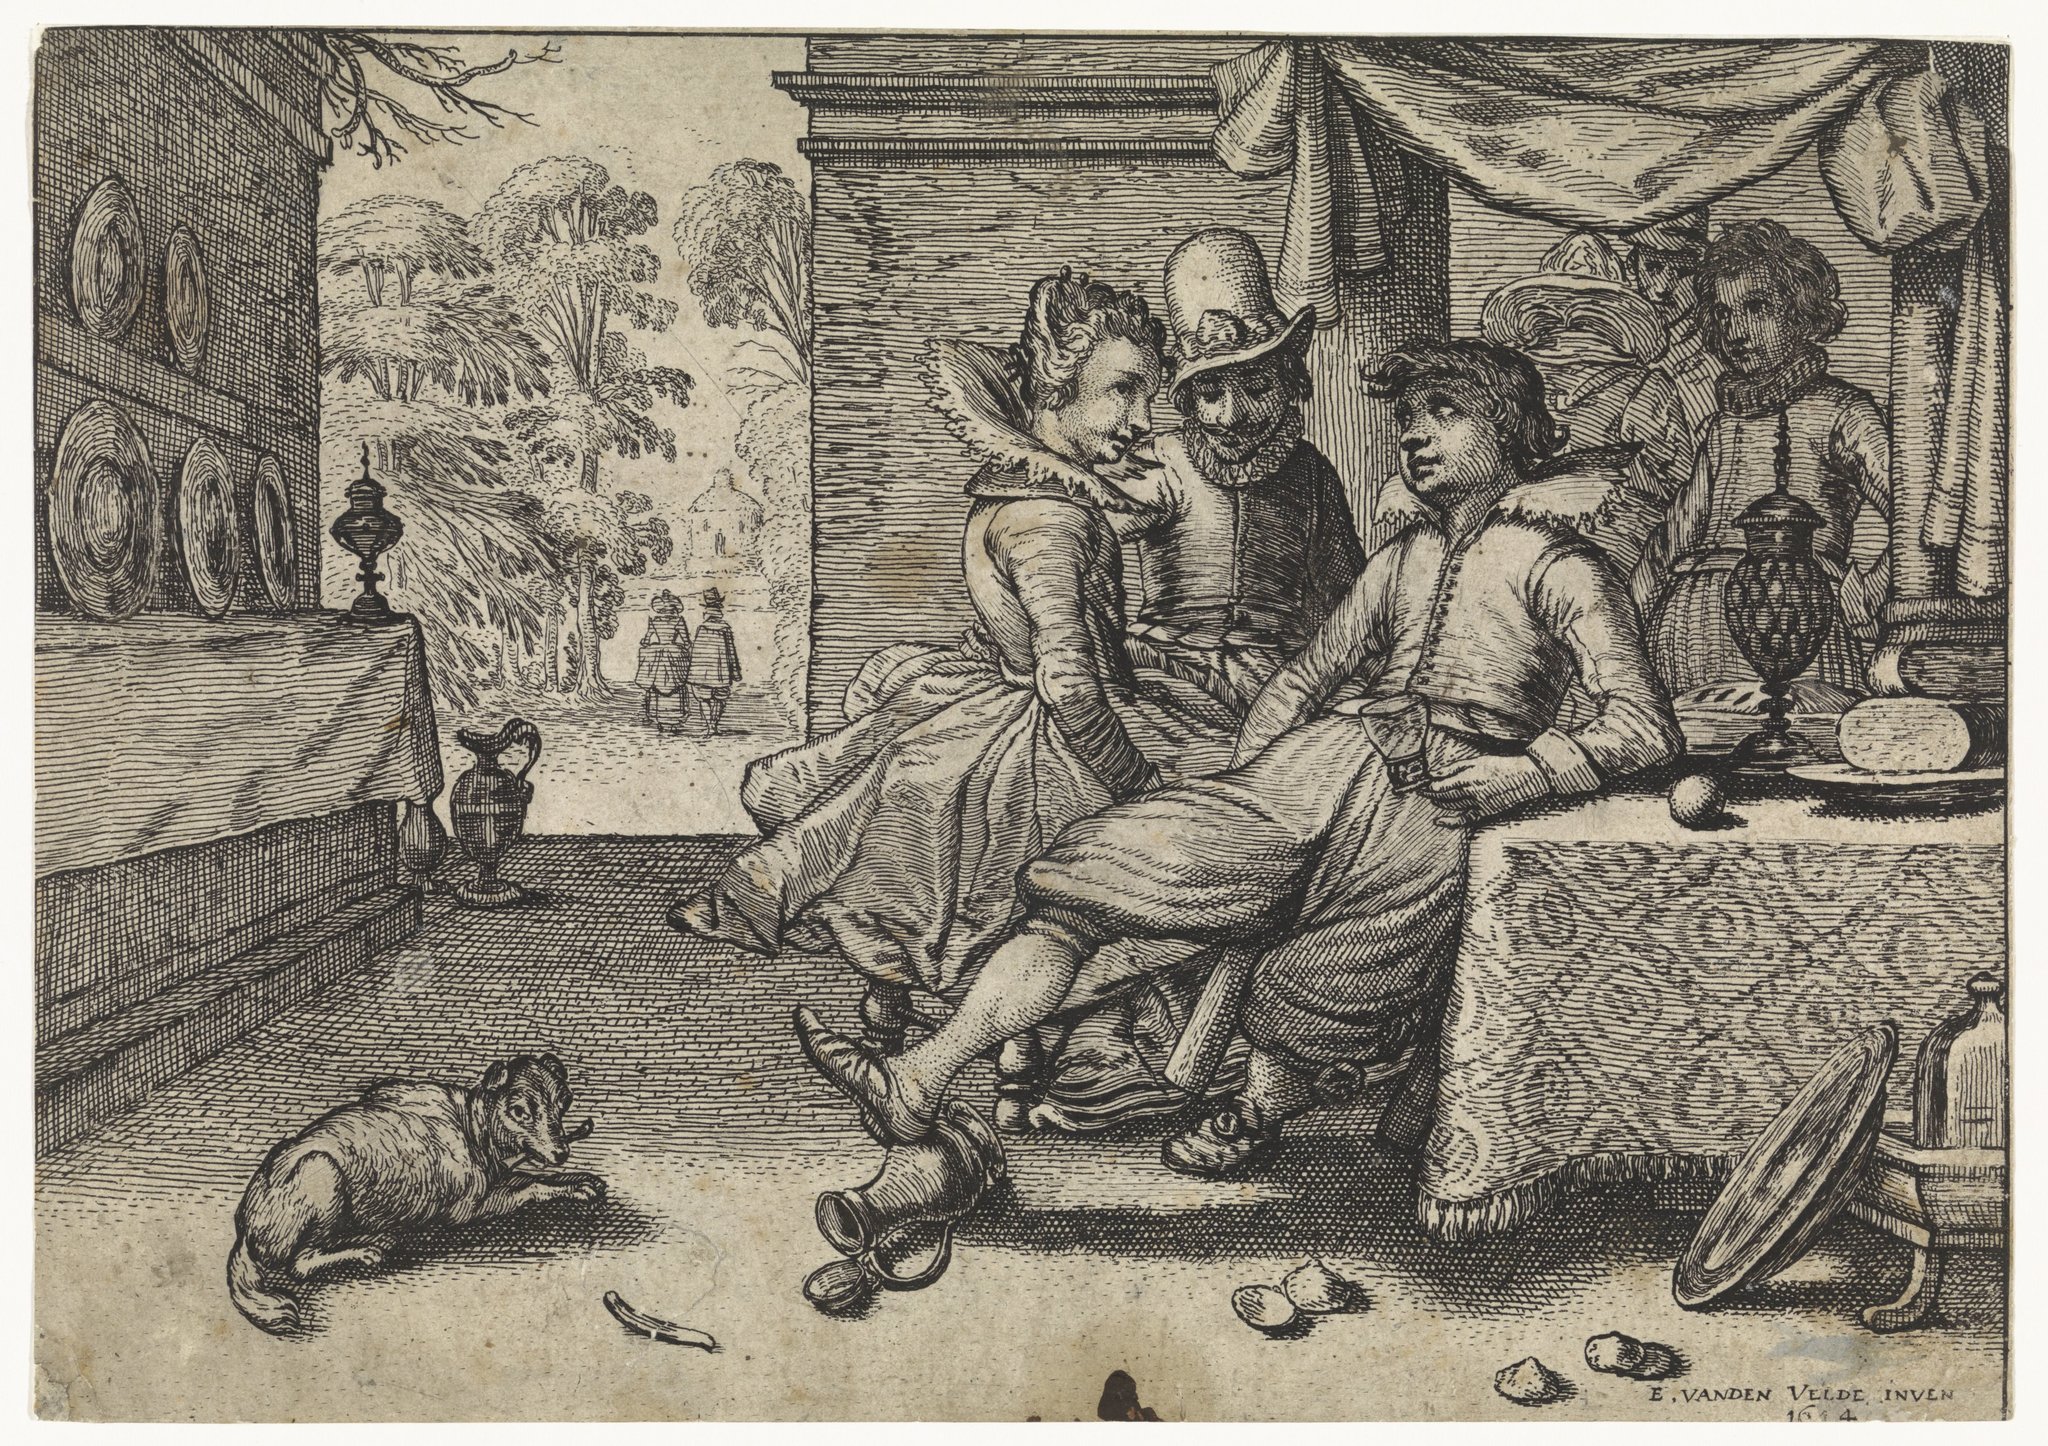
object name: print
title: Elegant gezelschap aan gedekte tafel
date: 1614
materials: paper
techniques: engraving, etching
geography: amsterdam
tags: private festivities, merry company - aa - in the open air, 'fête champêtre', laid table: table-ware, table-decoration, etc., wine-cooler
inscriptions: collector's mark: Lugt 240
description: Kleding: